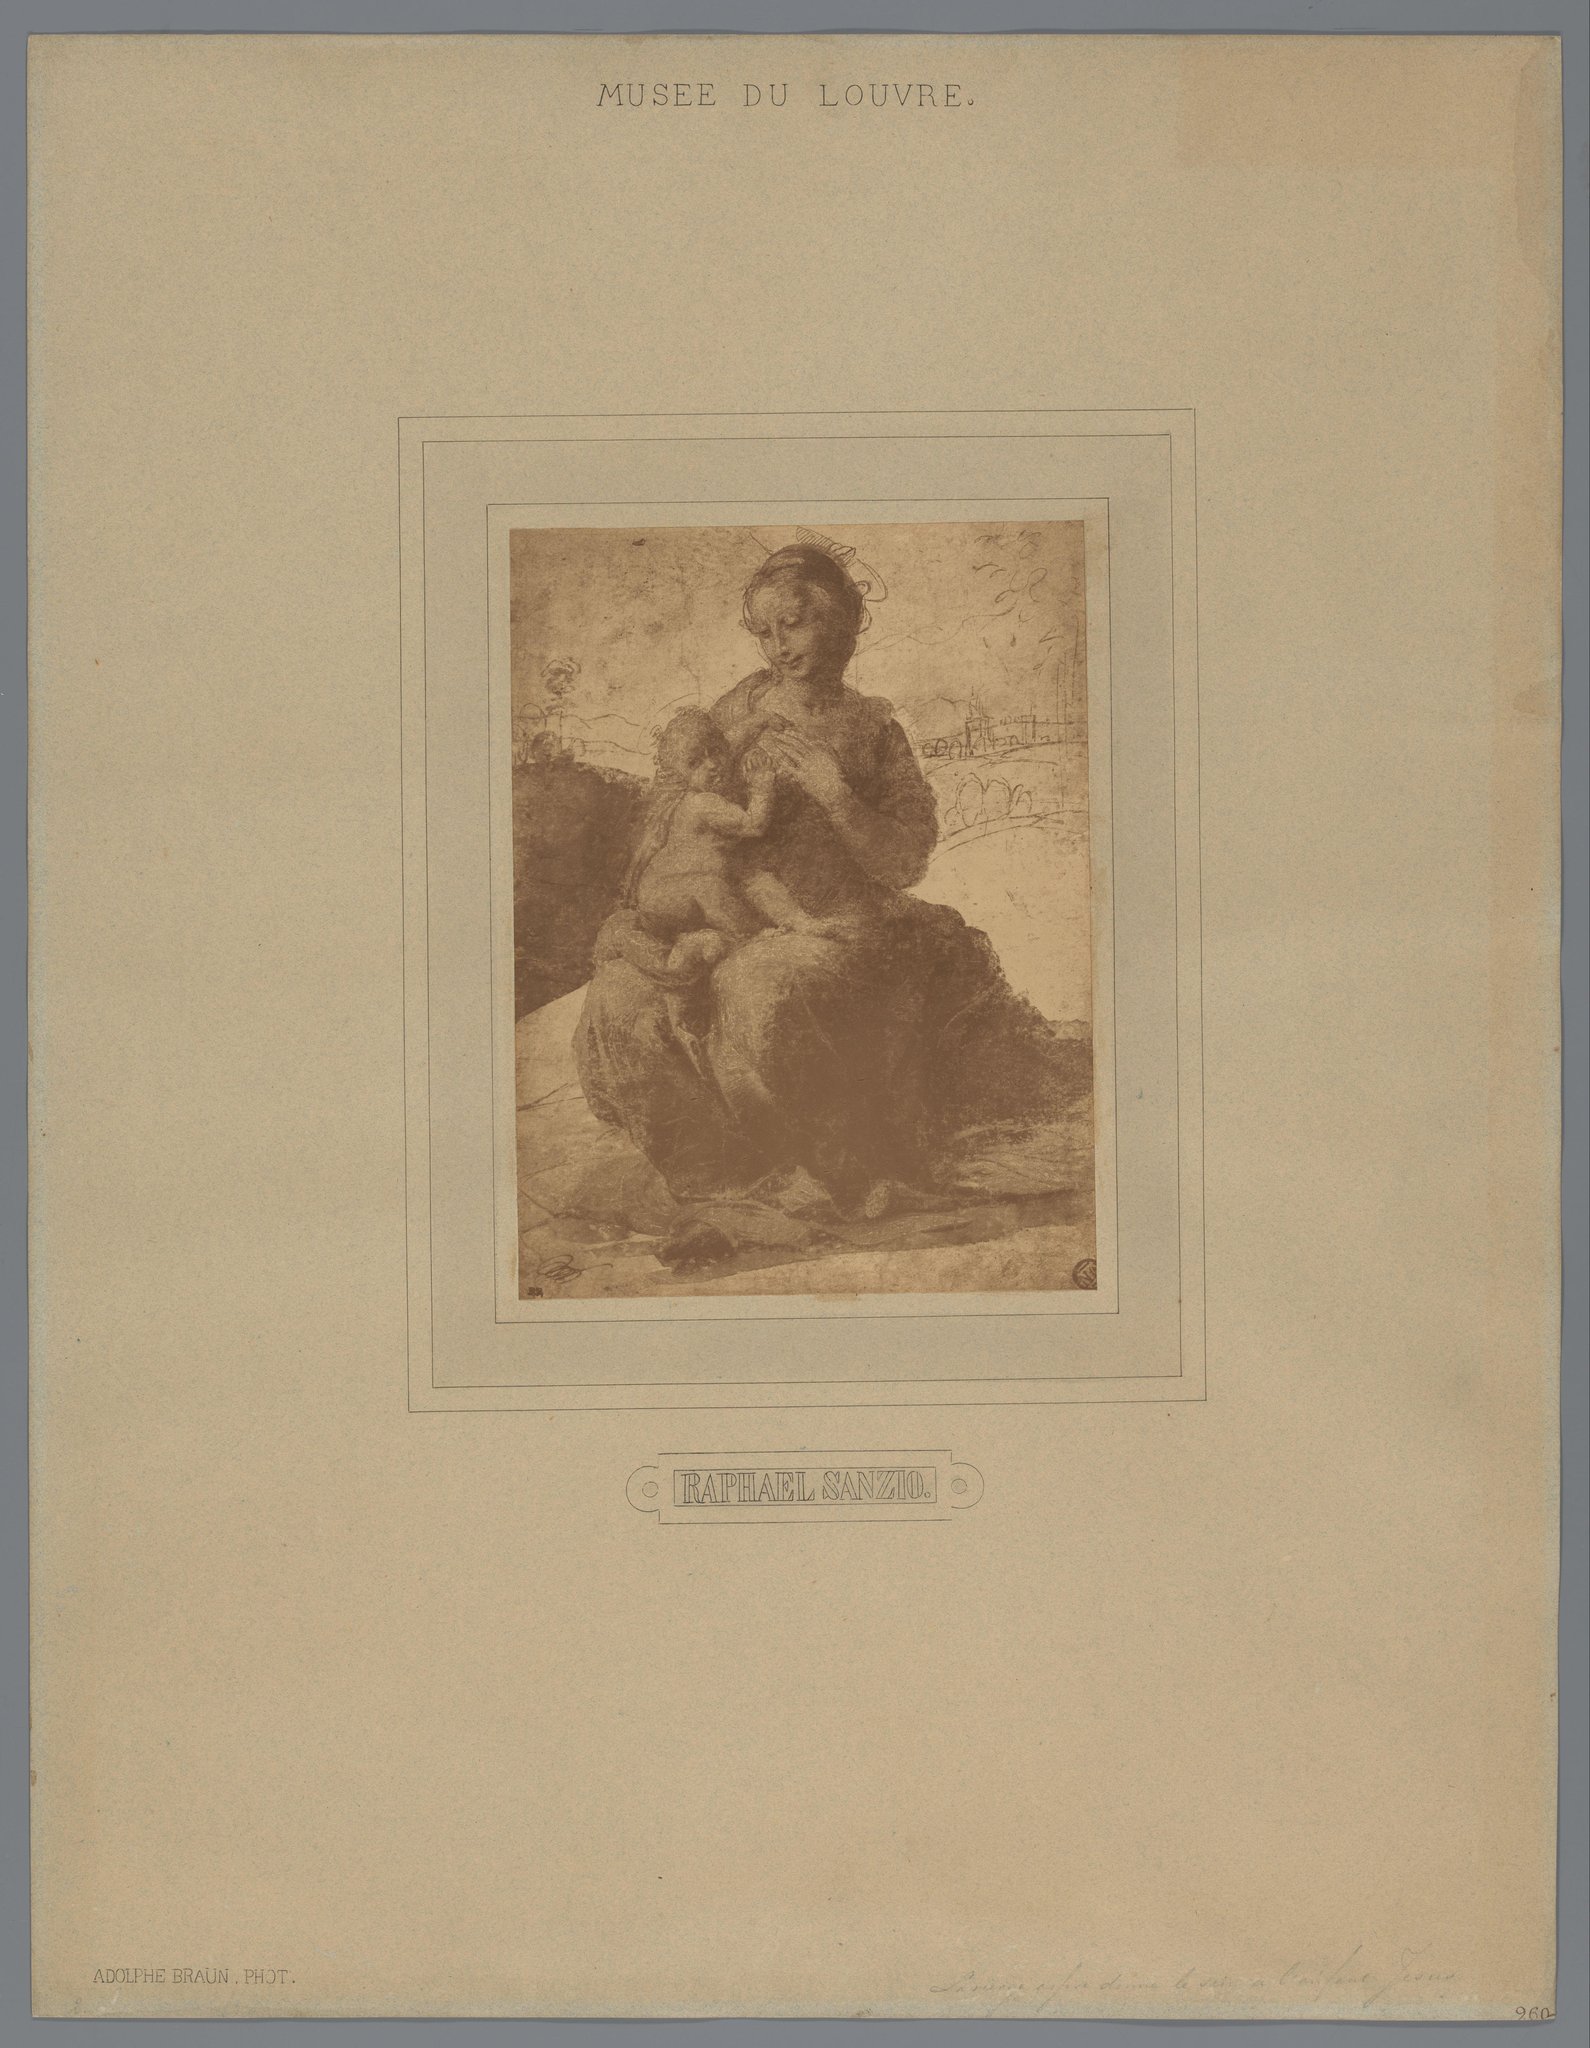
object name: photograph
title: Fotoreproductie van een tekening van Rafaël (Madonna met kind) (coll. Louvre)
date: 1880-1900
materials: cardboard, paper, photographic support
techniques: carbon print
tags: musée du louvre